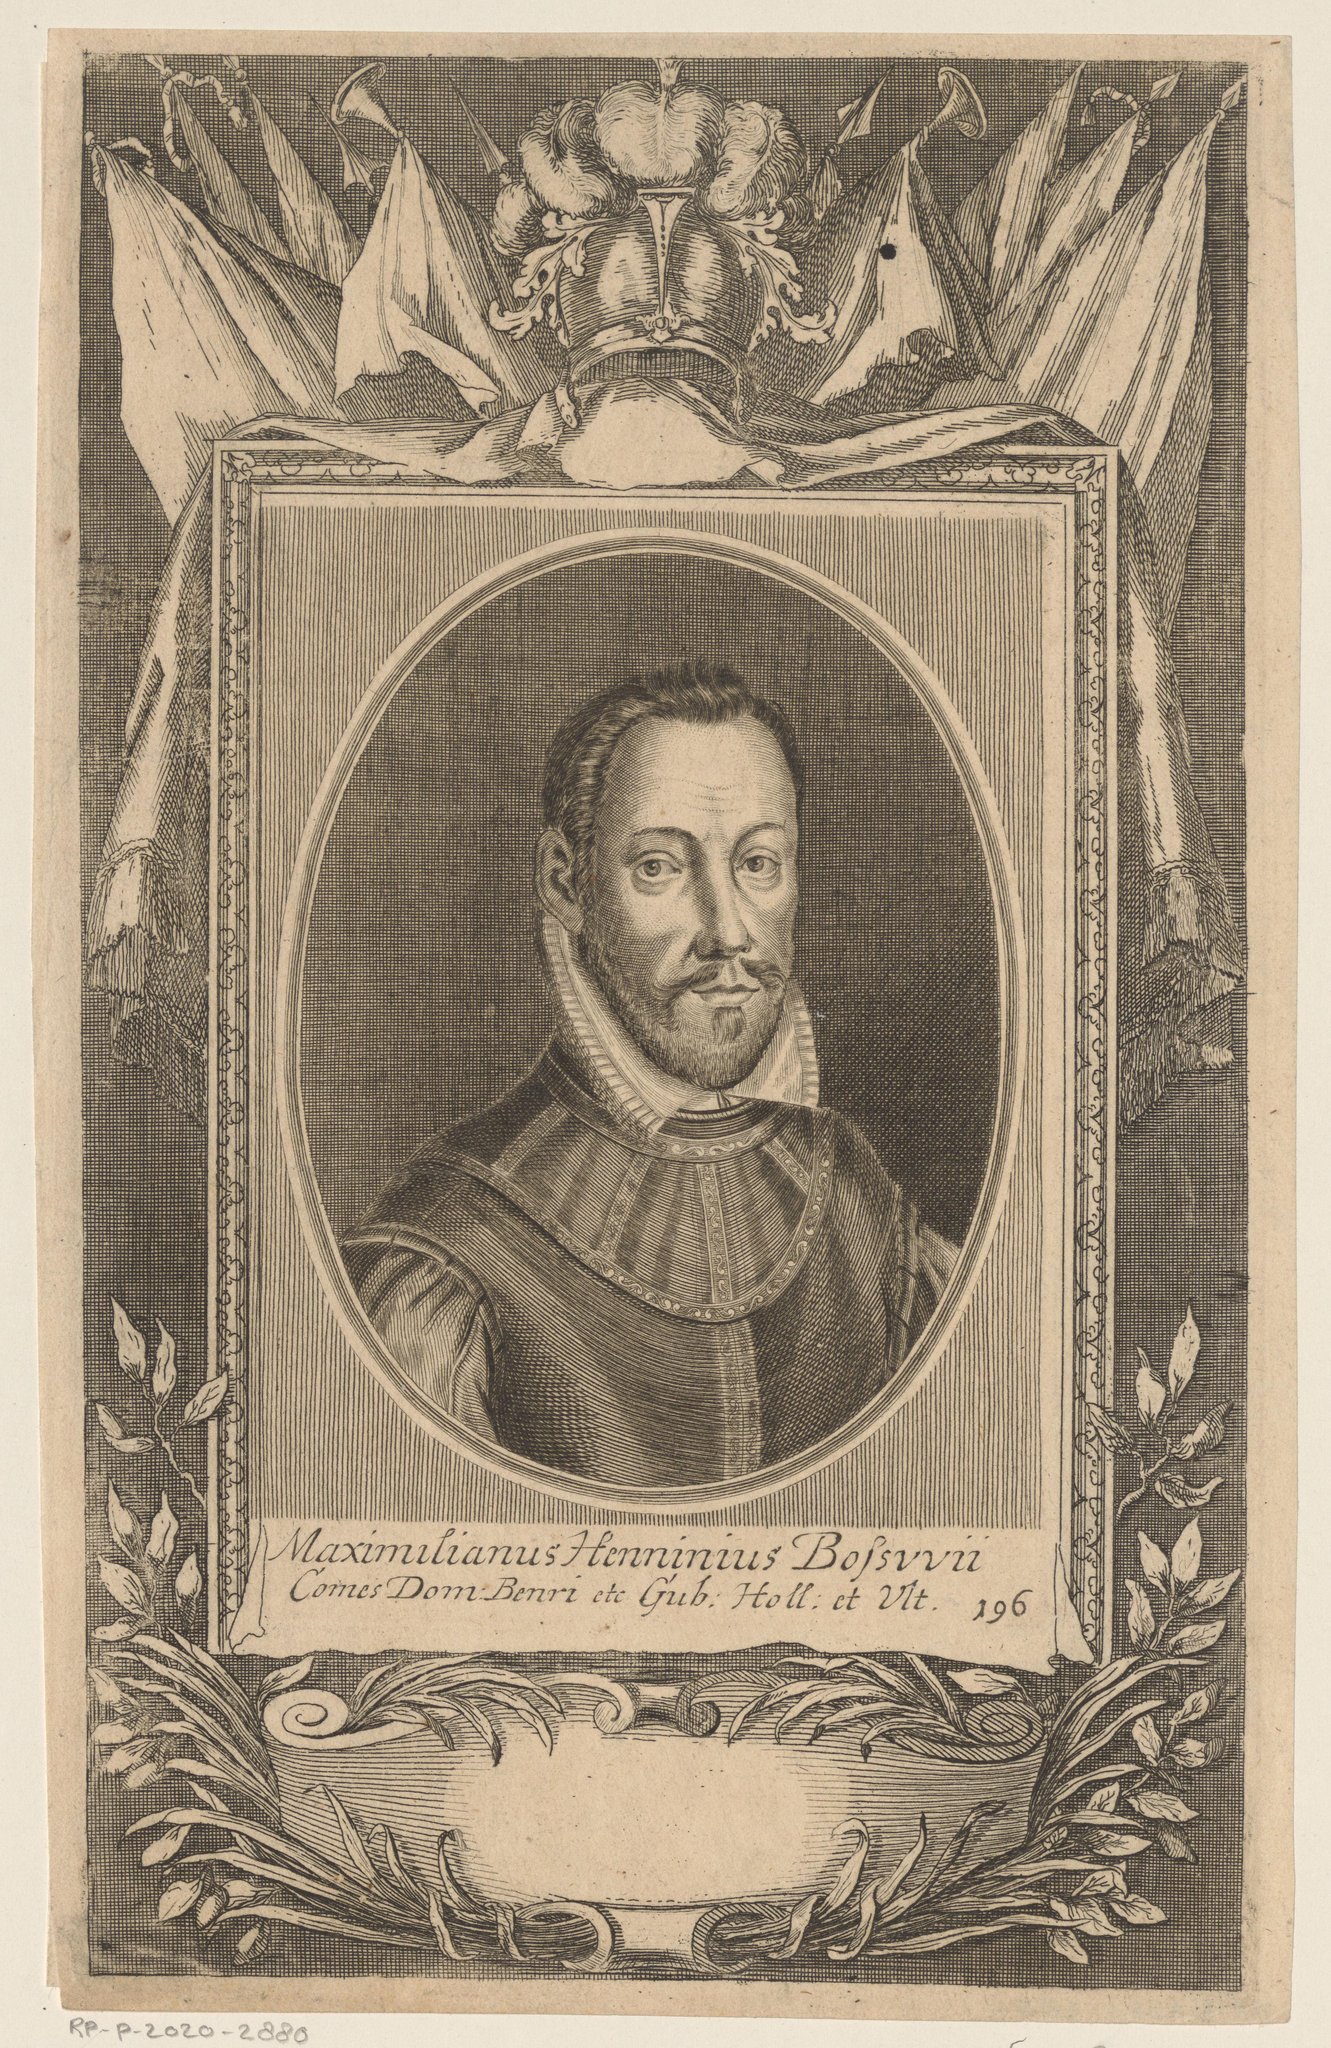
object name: print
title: Portret van Maximiliaan, graaf van Hennin-Lietard en Boussu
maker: Anonymous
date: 1700-1749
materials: paper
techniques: engraving, etching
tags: antwerp, earl, historical persons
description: Prent zonder nummer en met andere omlijsting gebruikt in: Conterfet Kupferstich (...). Leipzig: Moritz Georg Weidmann, 1721.